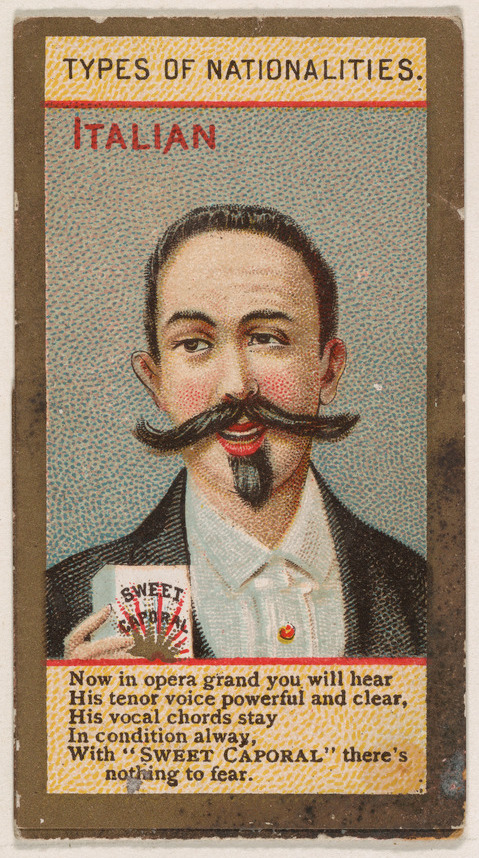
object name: print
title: Italian, from Types of Nationalities (N240) issued by Kinney Bros.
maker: kinney brothers tobacco company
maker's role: publisher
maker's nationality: american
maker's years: 1869-2011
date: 1890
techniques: color lithograph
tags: men